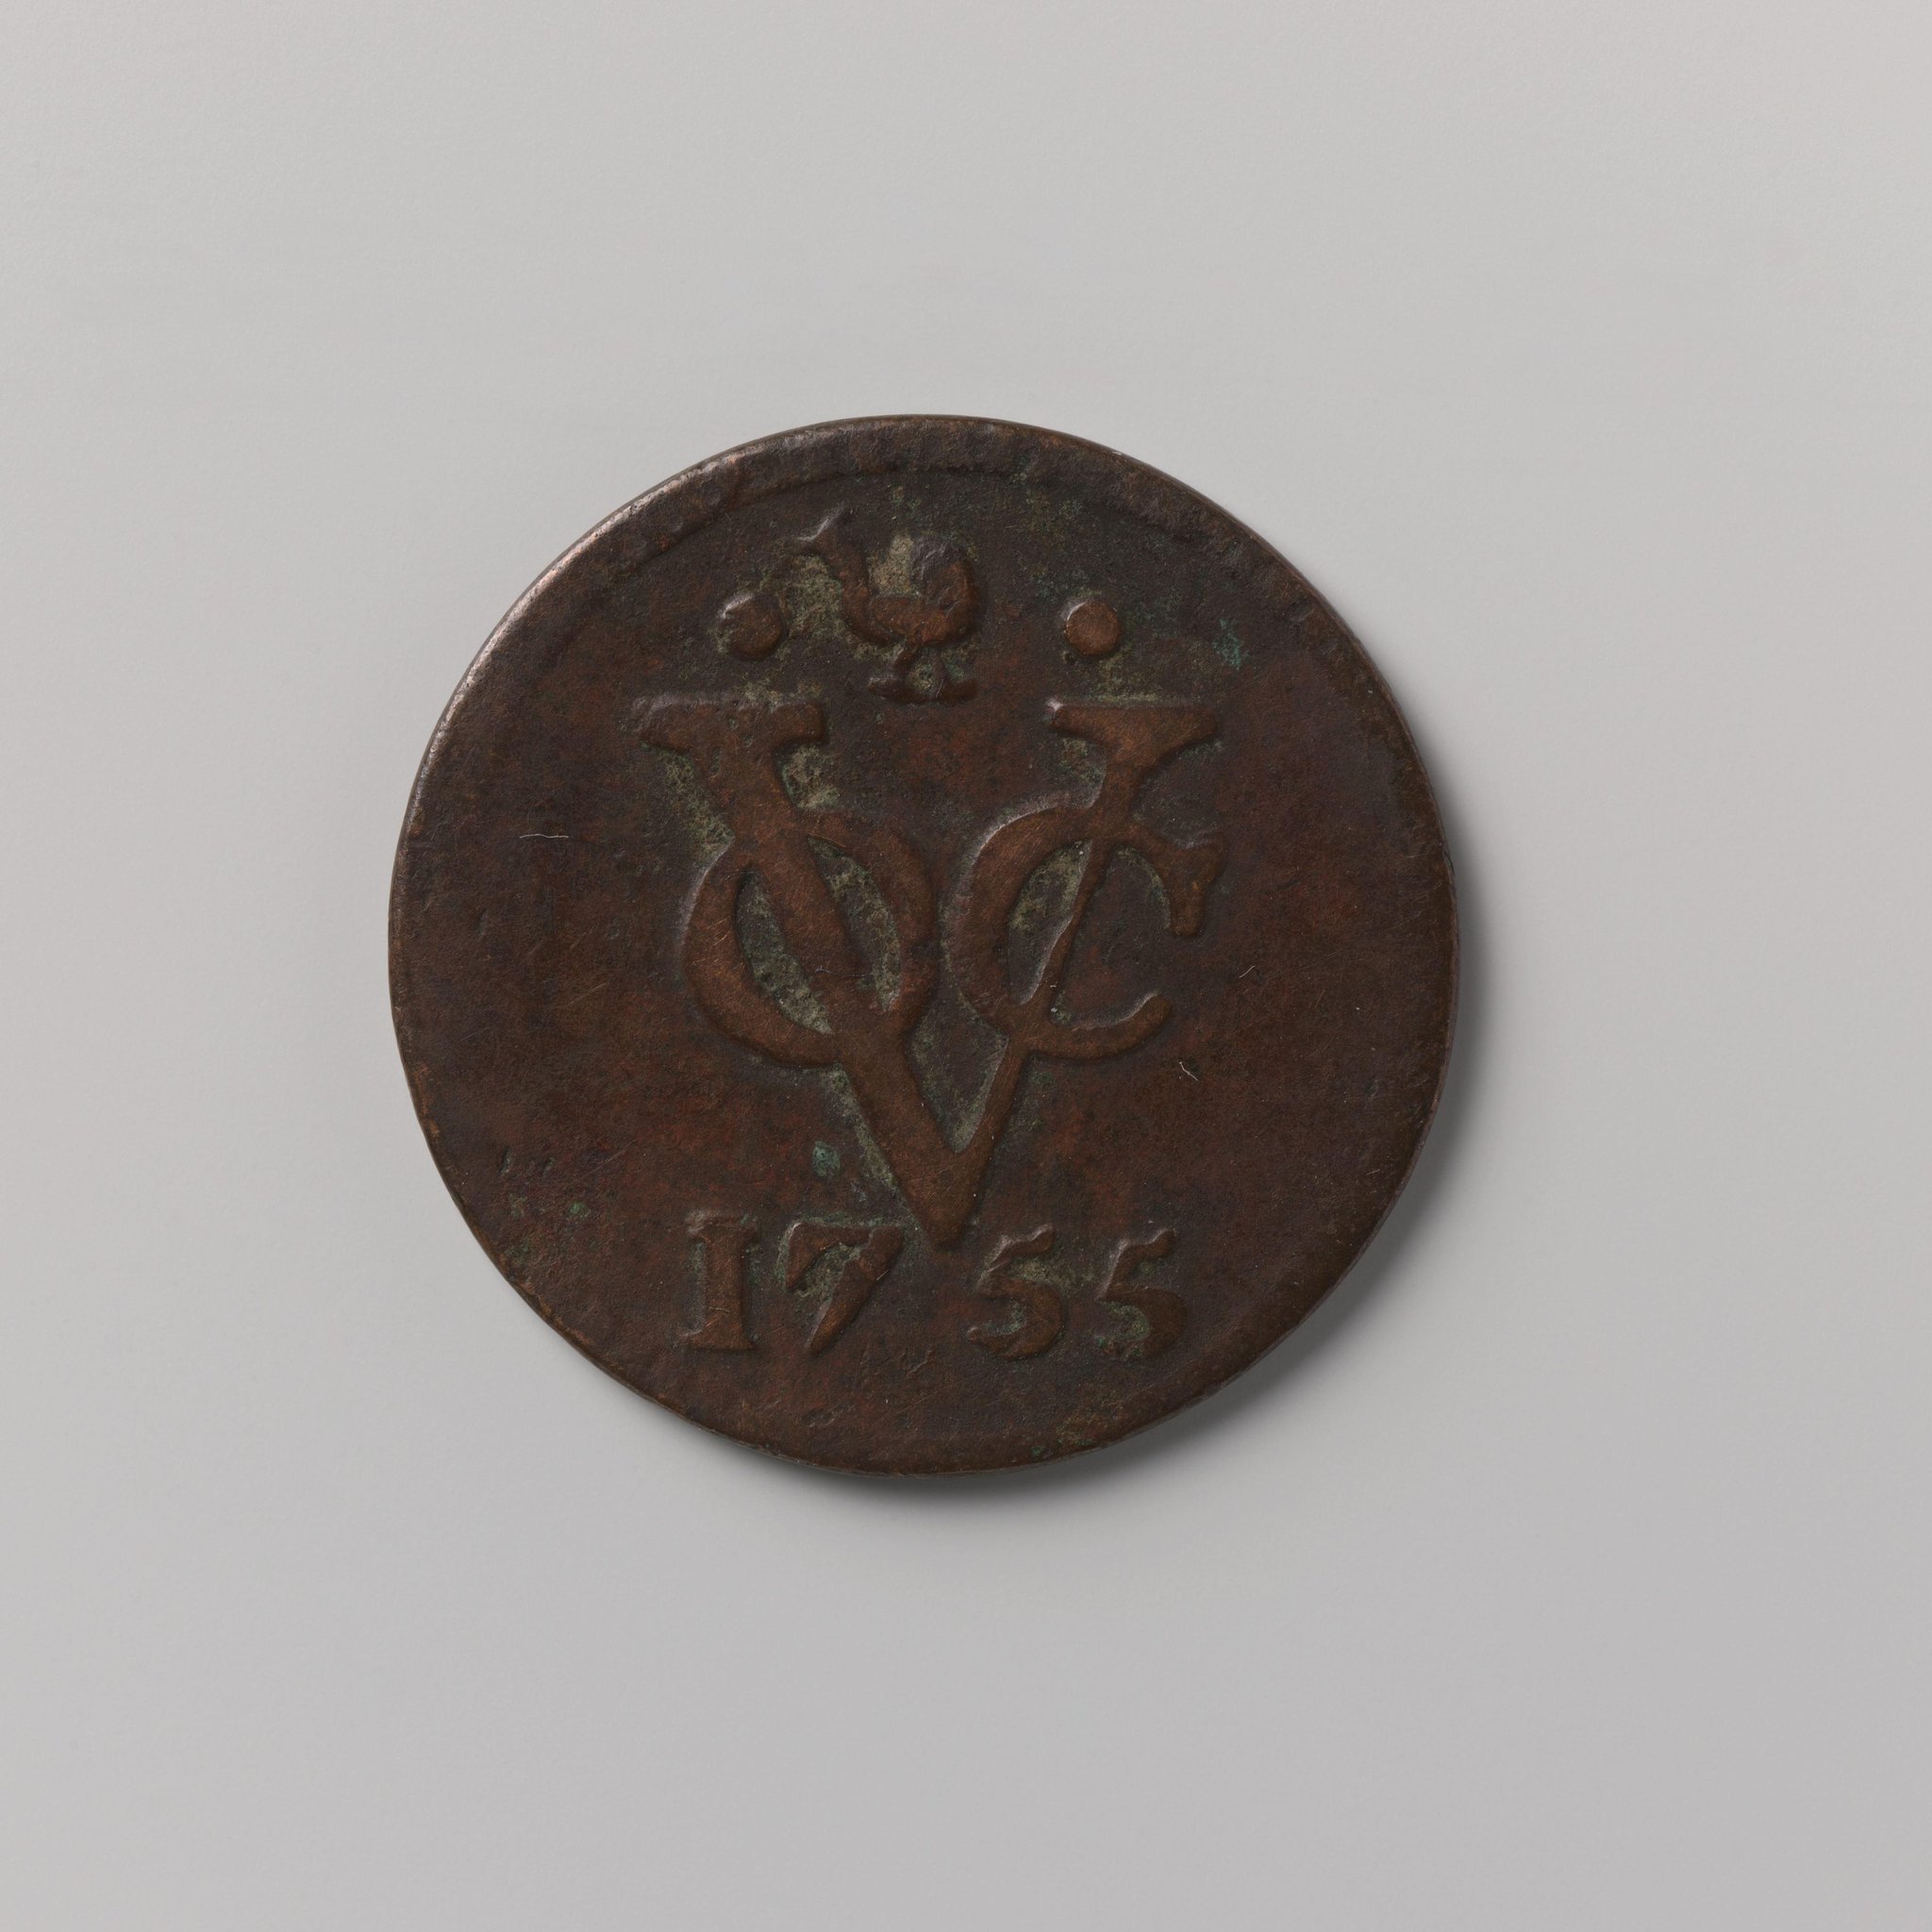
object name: coin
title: VOC, duit Westfriesland, 1755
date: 1755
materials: copper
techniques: striking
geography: hoorn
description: Koperen munt. Voorzijde: gekroond wapenschild van Westfriesland. Keerzijde: monogram van de VOC, waarboven muntmeesterteken en waaronder jaartal. Gladde rand.